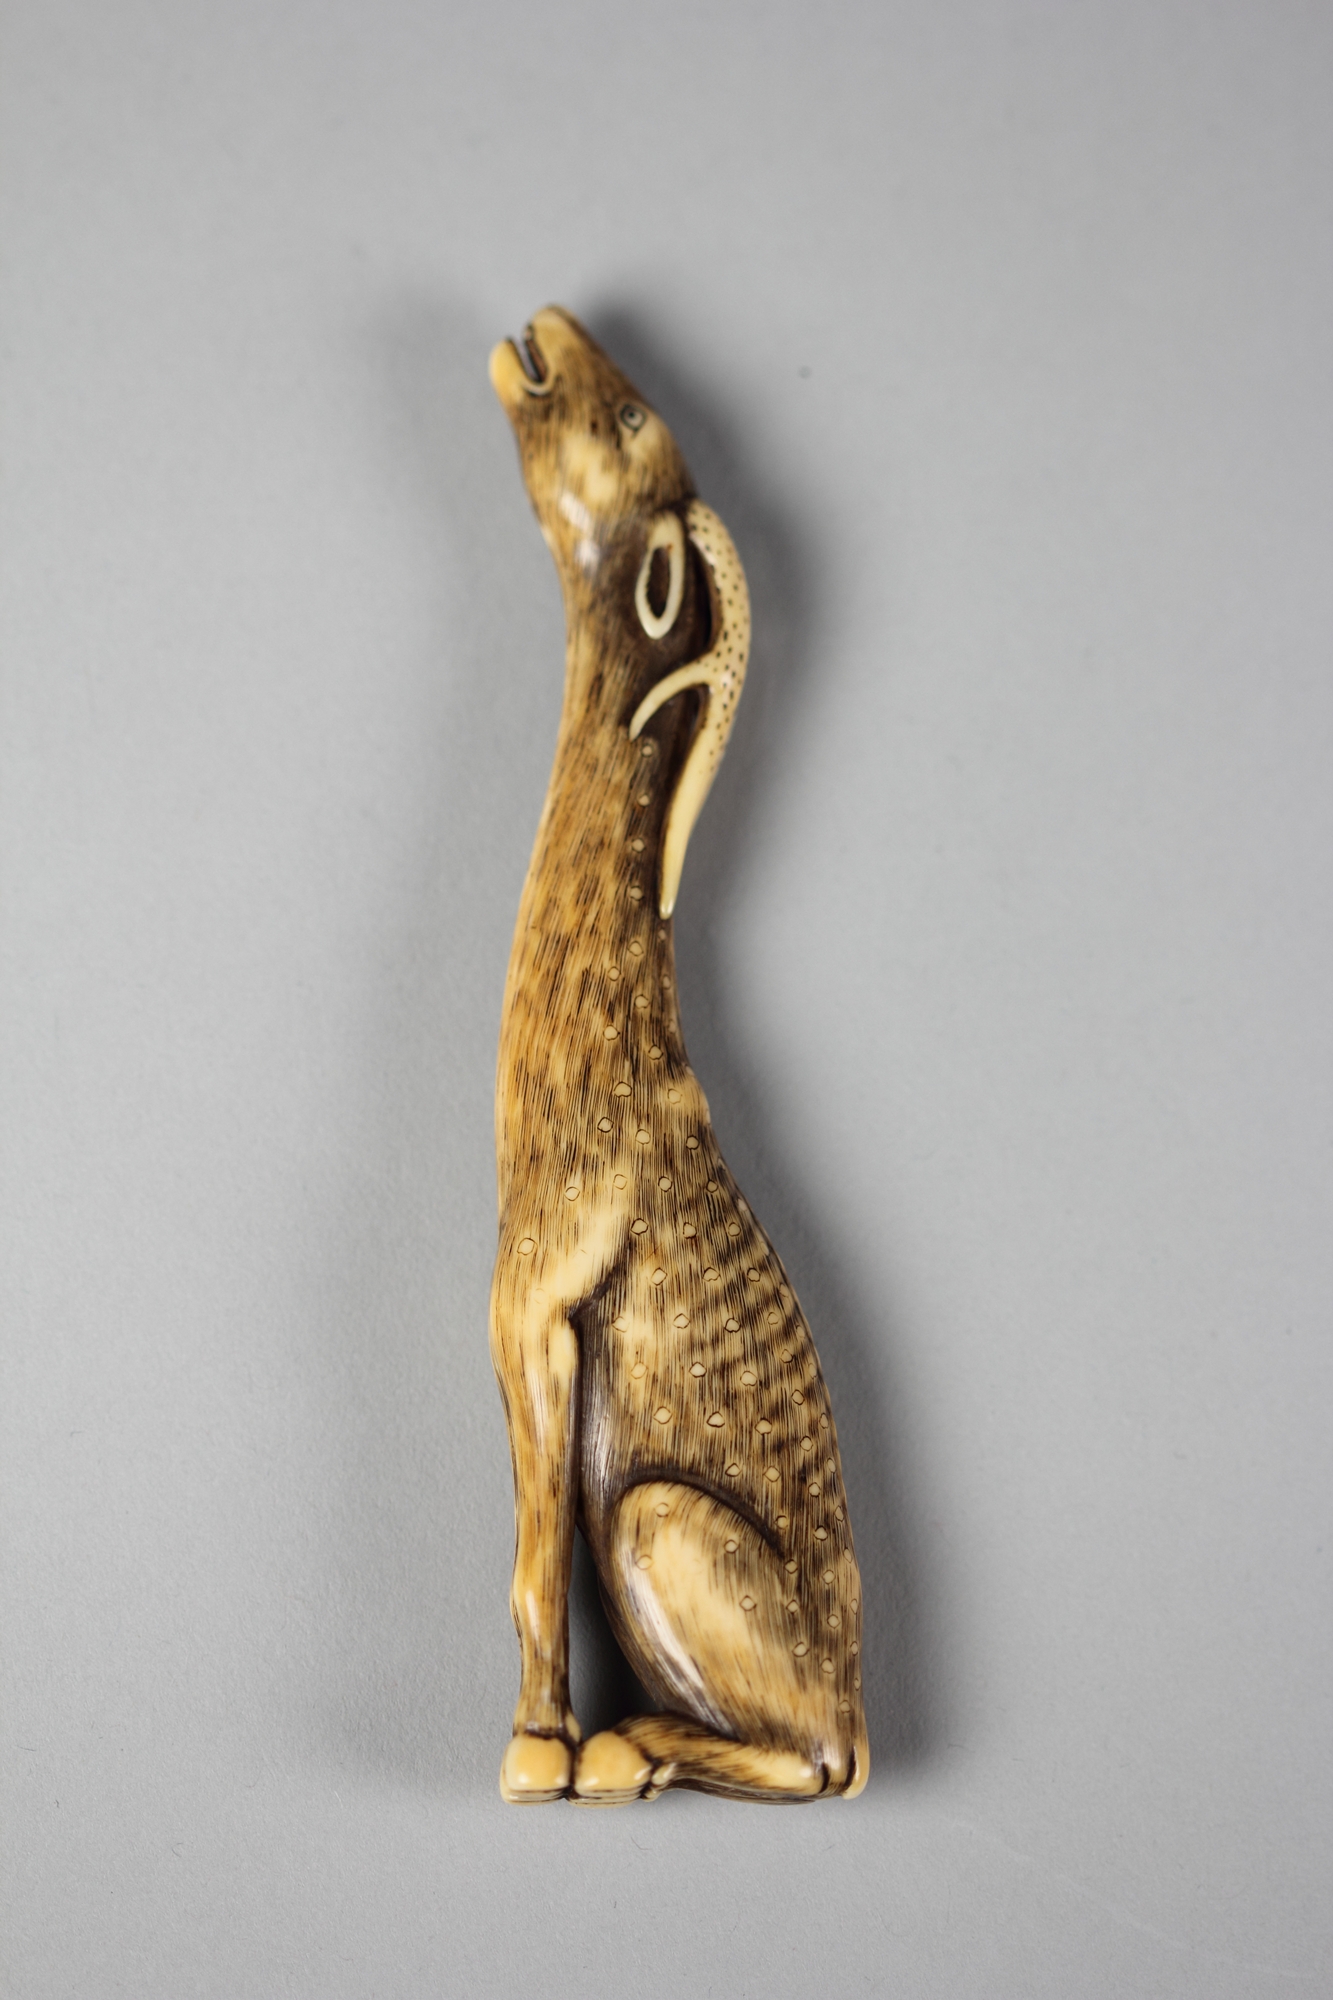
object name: netsuke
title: Stag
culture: japanese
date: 1851-1900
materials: ivory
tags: deer